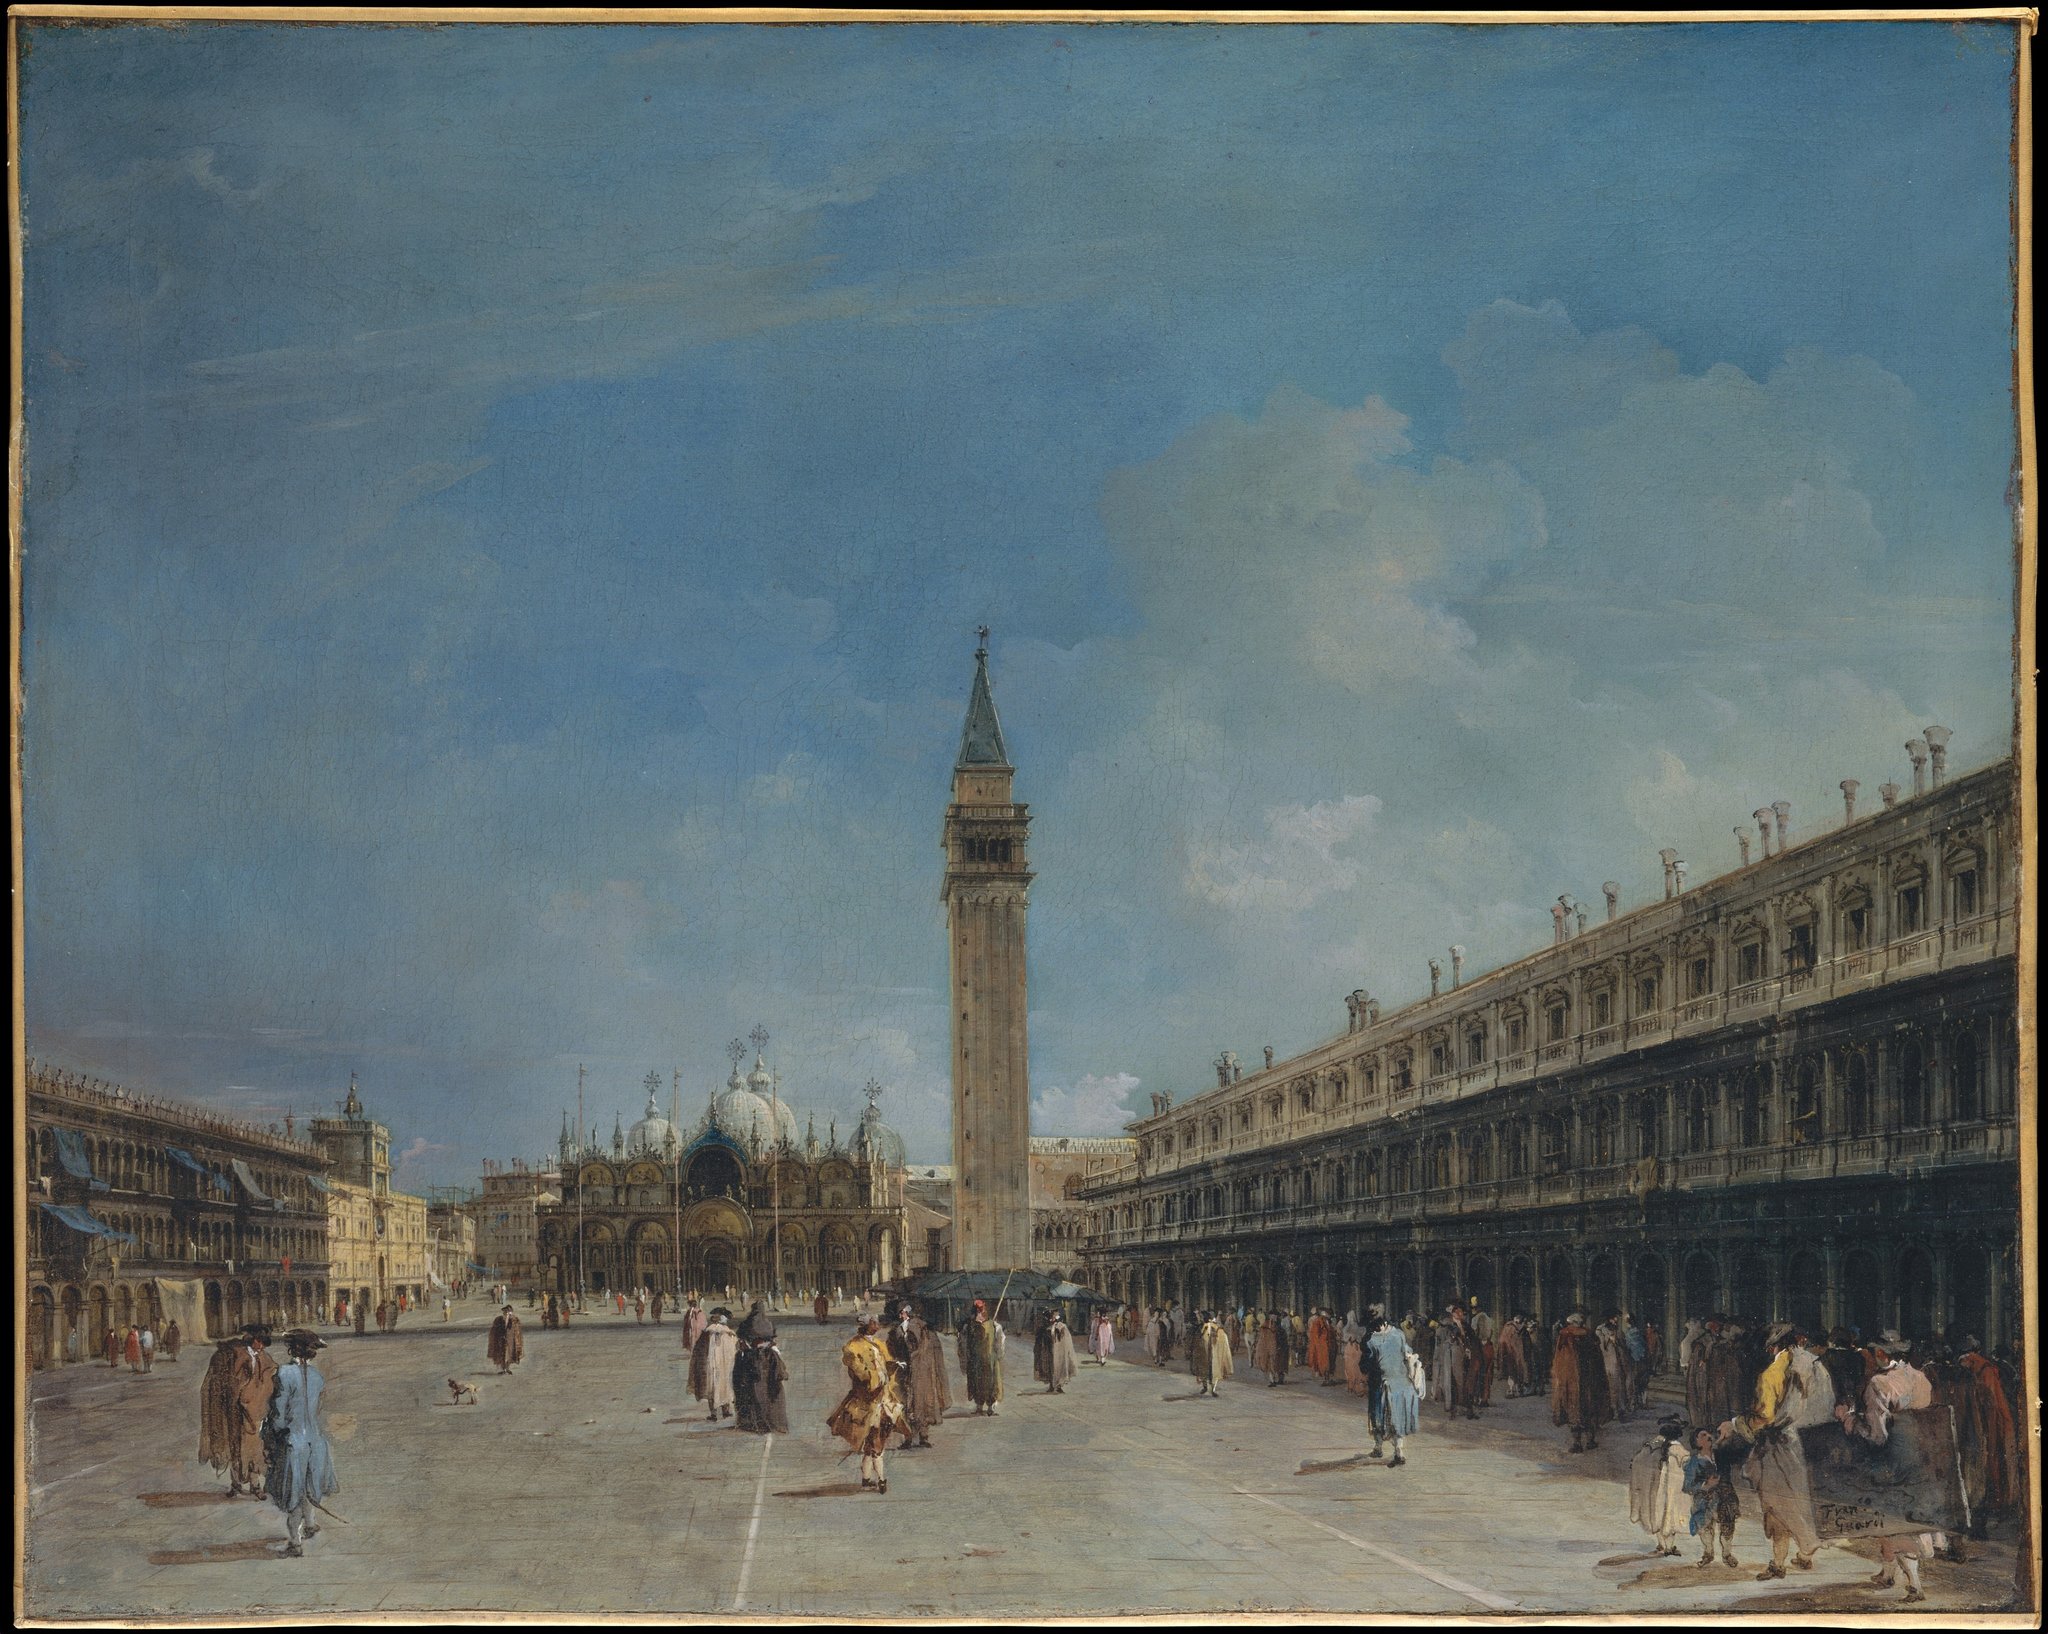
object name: painting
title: Piazza San Marco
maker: francesco guardi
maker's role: artist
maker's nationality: italian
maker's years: 1712-1793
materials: canvas, oil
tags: buildings,towers,cities,venice